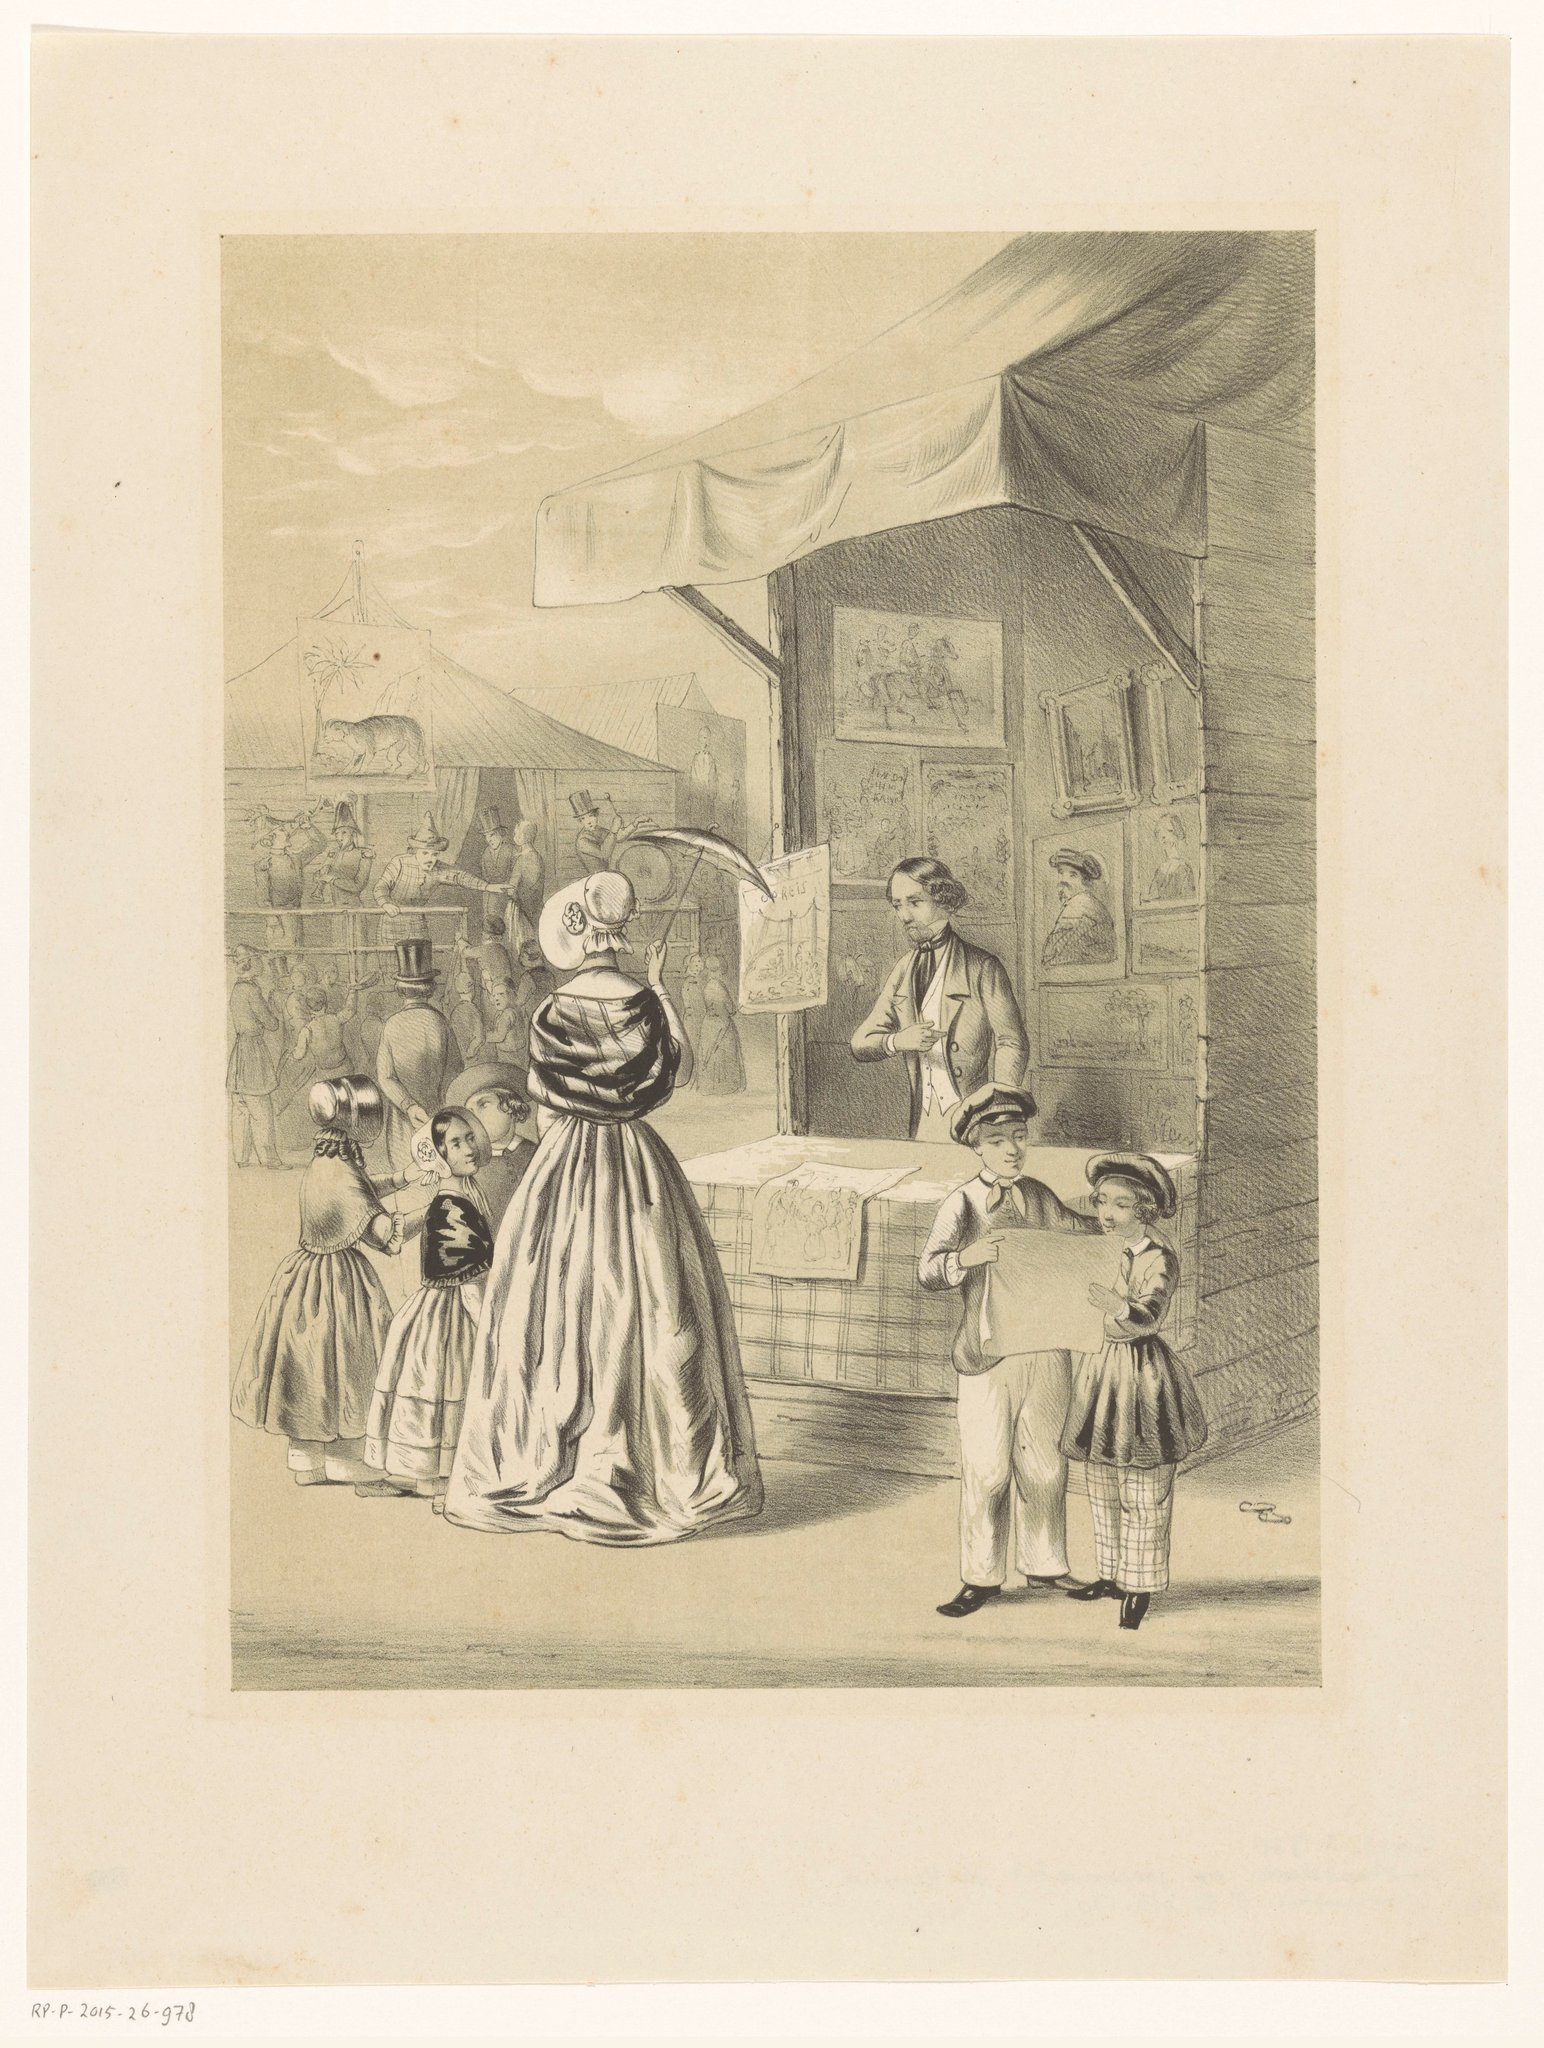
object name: print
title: Prenthandelaar op de kermis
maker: Anonymous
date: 1825-1850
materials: paper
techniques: hand coloring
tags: print, e.g.: engraving, etching, lithograph, pleasure fair and circus, drumming-up the public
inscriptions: collector's mark: Lugt 2228, collector's mark: Lugt 4780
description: Op de voorgrond bekijken twee kinderen een prent. In de achtergrond gaan mensen een circustent binnen. Voor de ingang staan twee mannen met blaasinstrumenten en een met een trom.